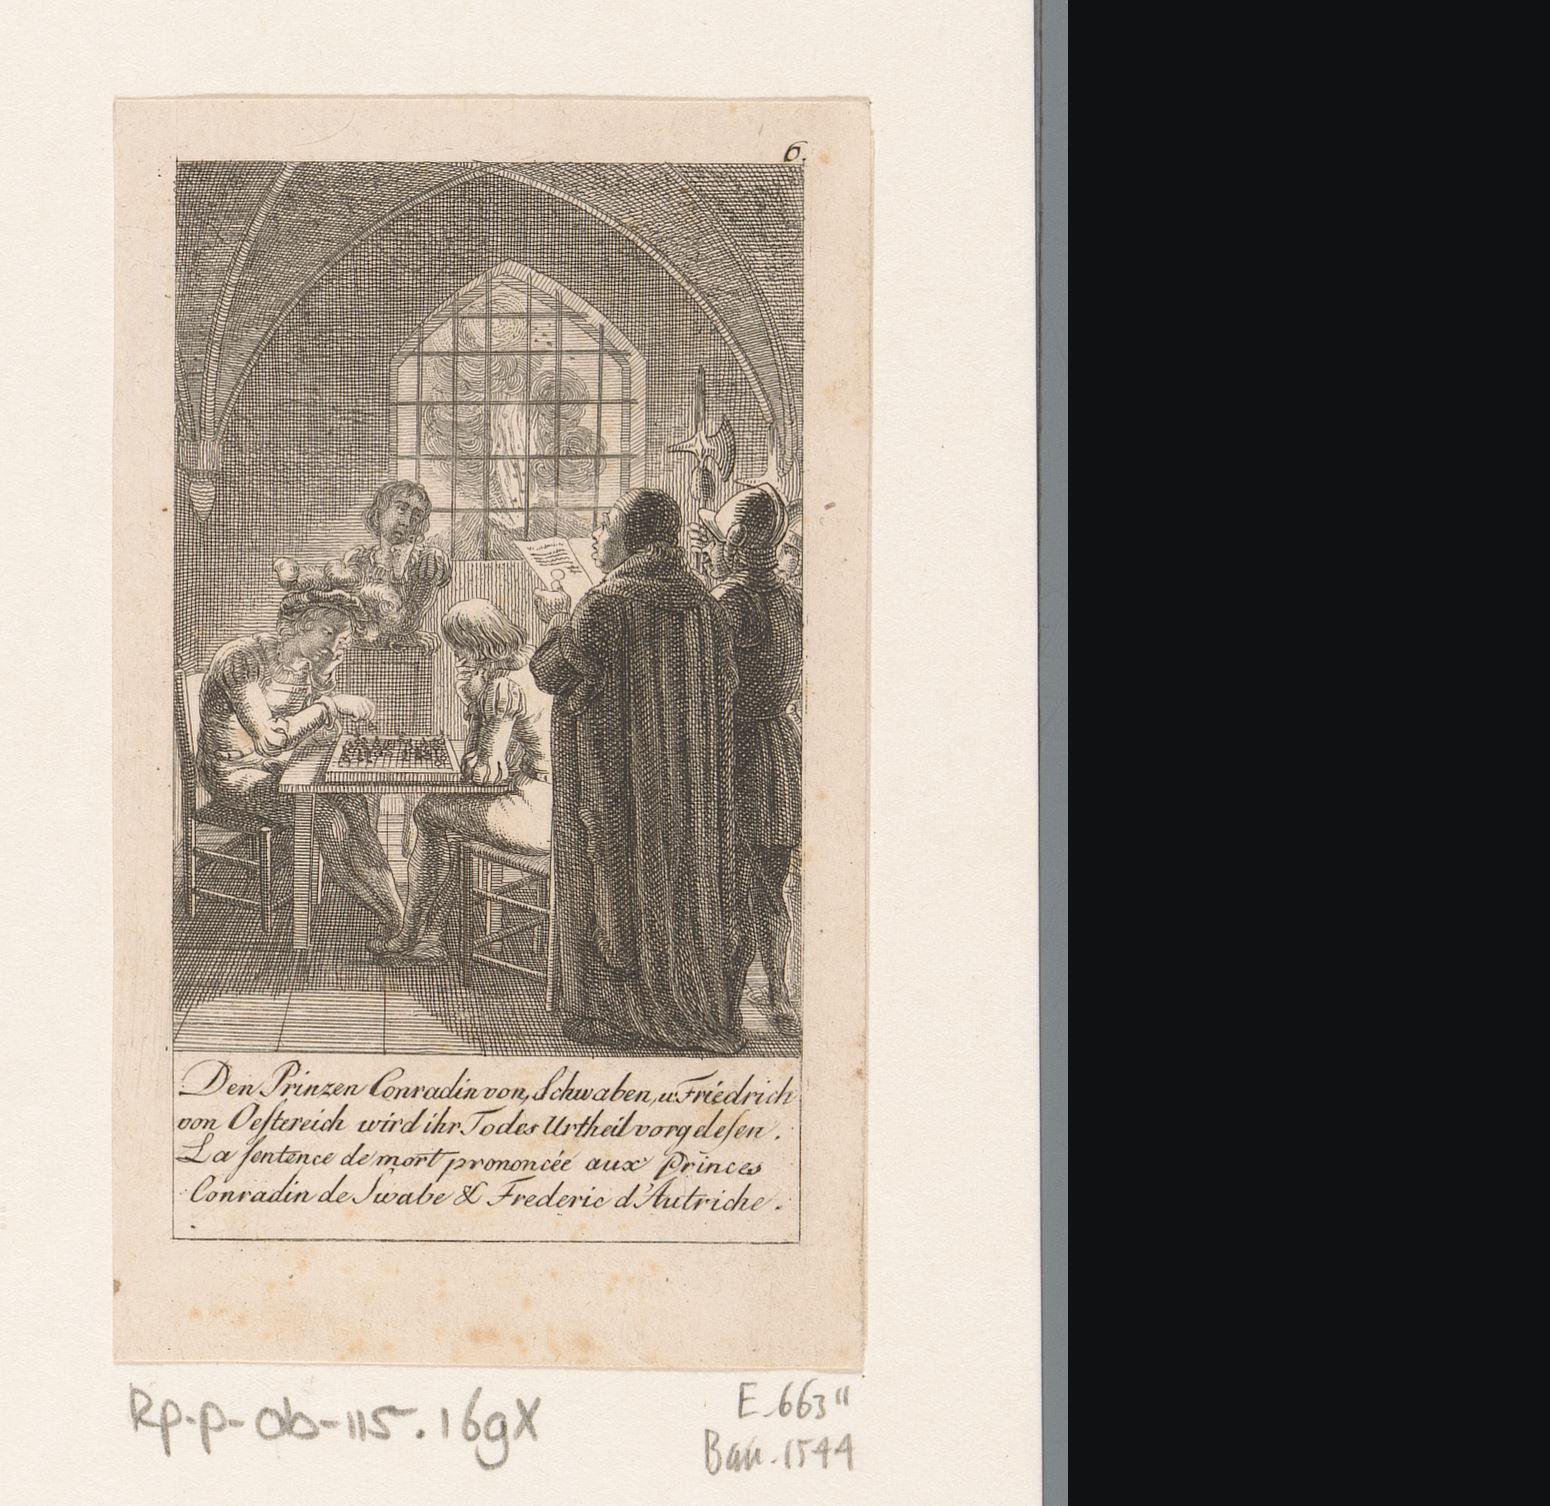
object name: book illustration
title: Frederik II schaakt tijdens zijn gevangenschap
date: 1791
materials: paper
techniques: etching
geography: gotha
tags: prison, jail, history, chess, volcano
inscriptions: collector's mark: Lugt 2228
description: Prent gebruikt voor: Gothaischer Hof Kalender, zum Nutzen und Vergnügen auf das Jahr 1792. Gotha: C. W. Ettinger, [1791].